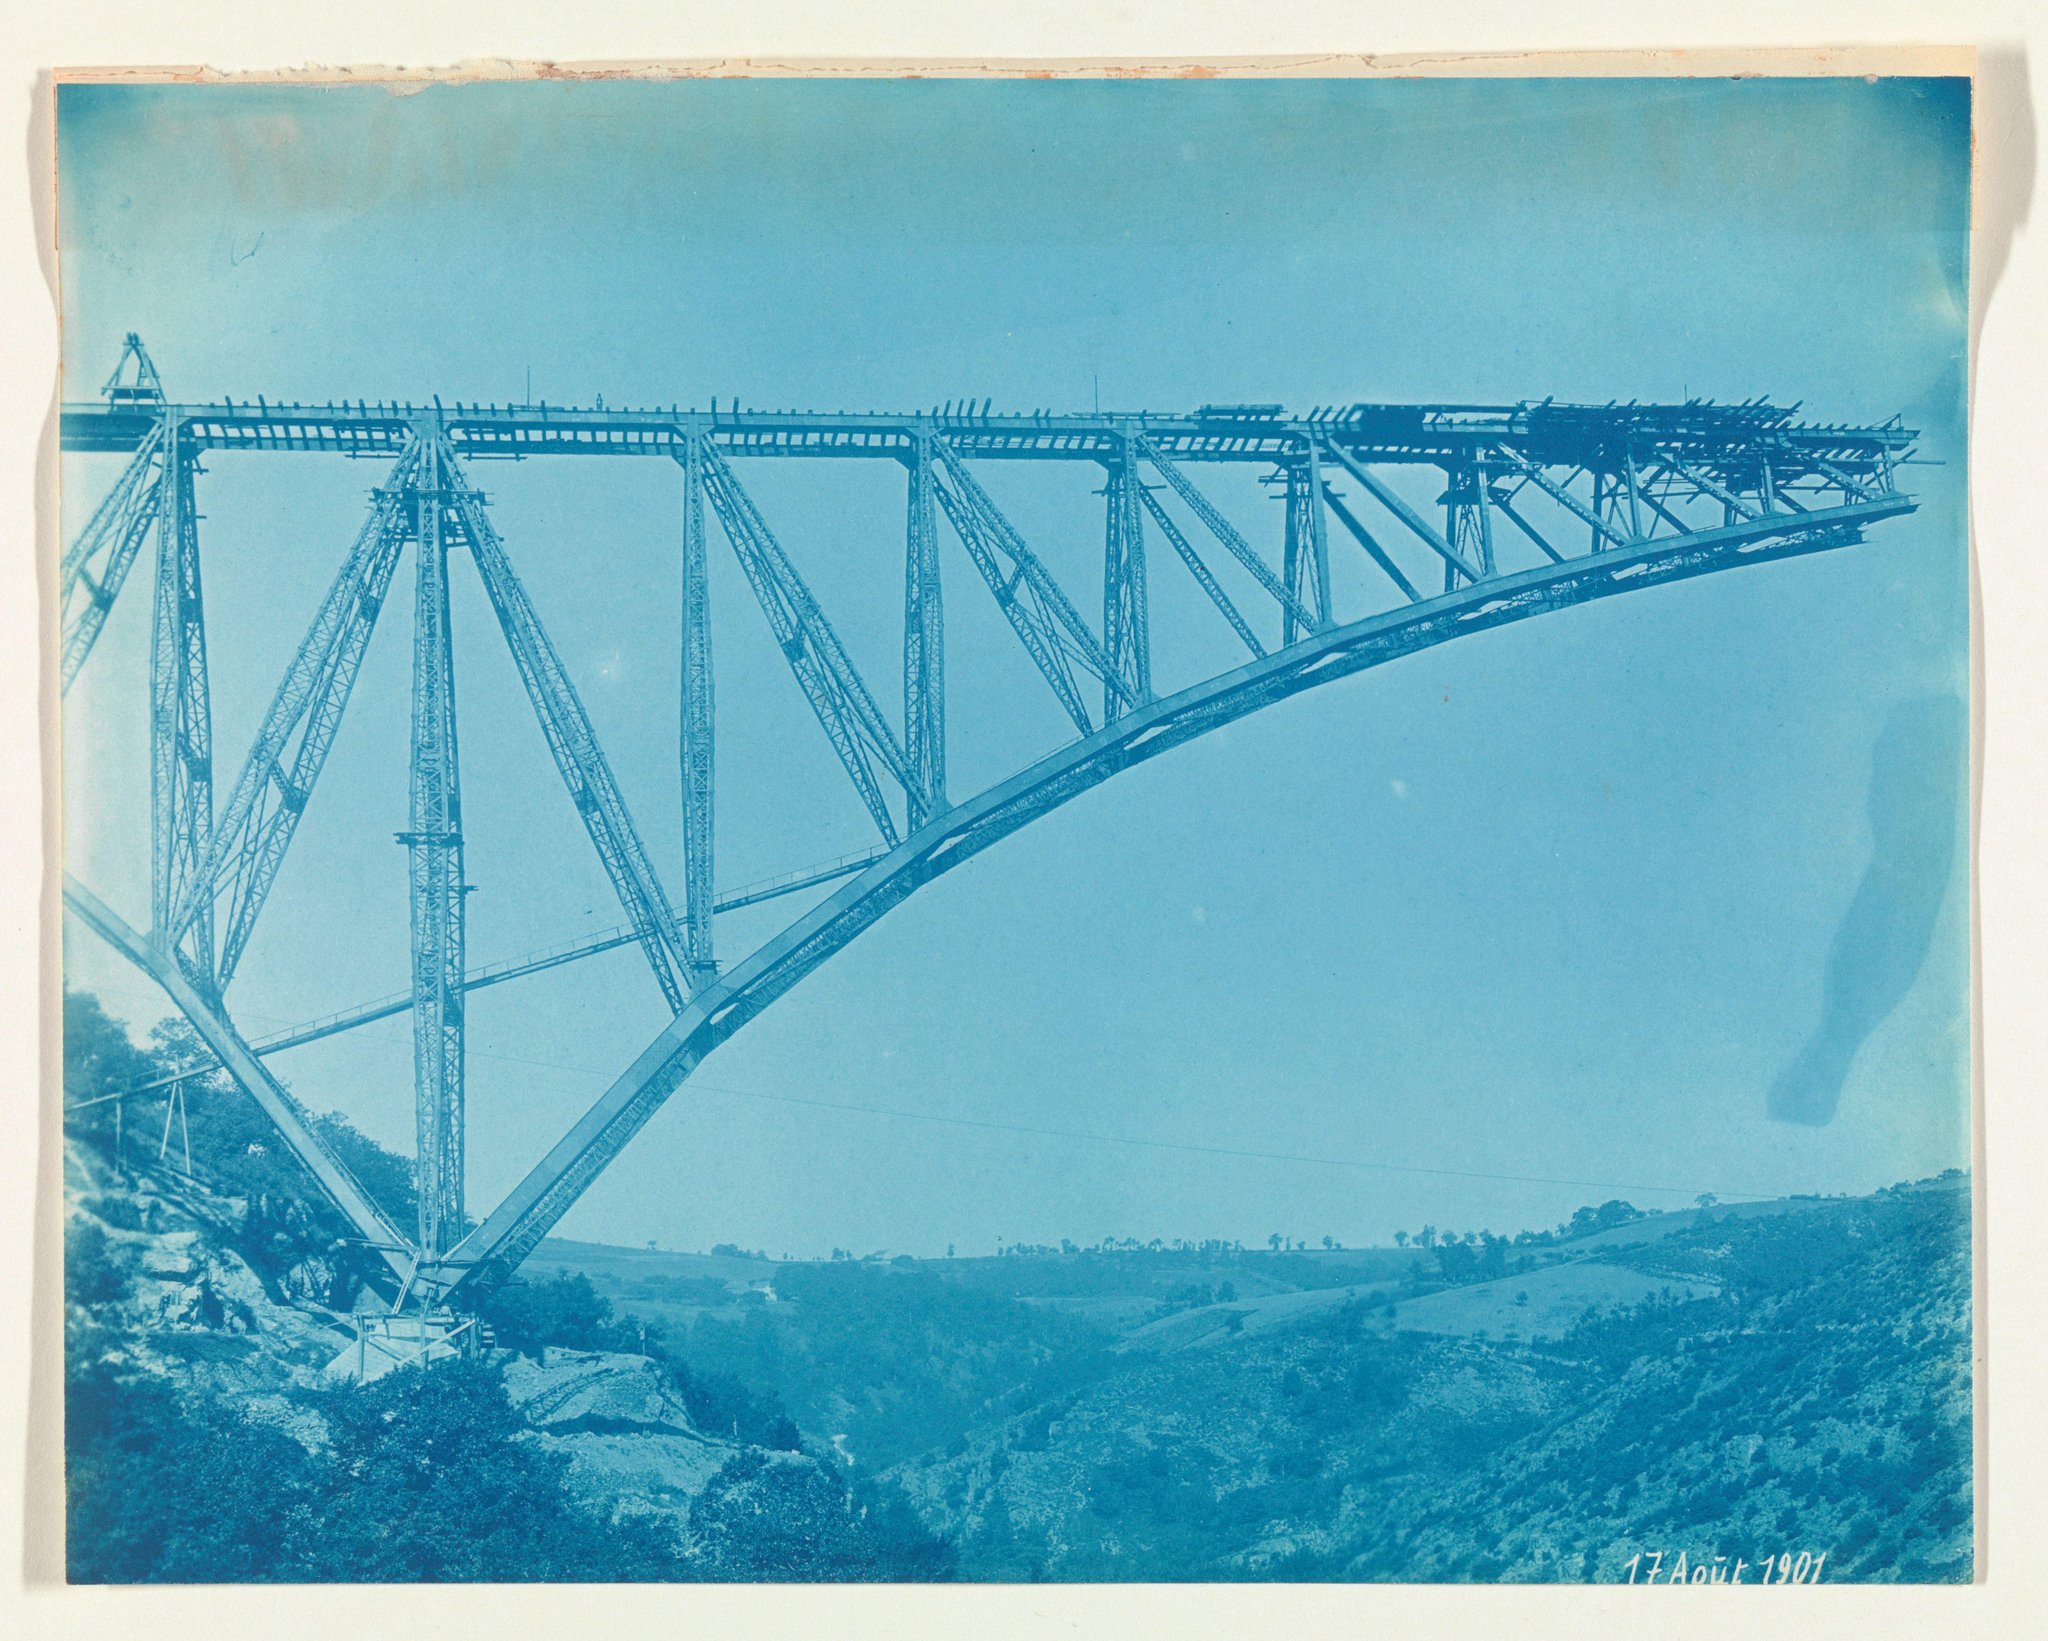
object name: photograph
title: Aanleg van het Viaur Viaduct in Frankrijk door de Societé de Construction des Battignolles, 17 augustus 1901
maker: Anonymous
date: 1901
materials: photographic support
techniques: cyanotype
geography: france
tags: viaduct, making the overground structures (~ building activities)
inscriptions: date